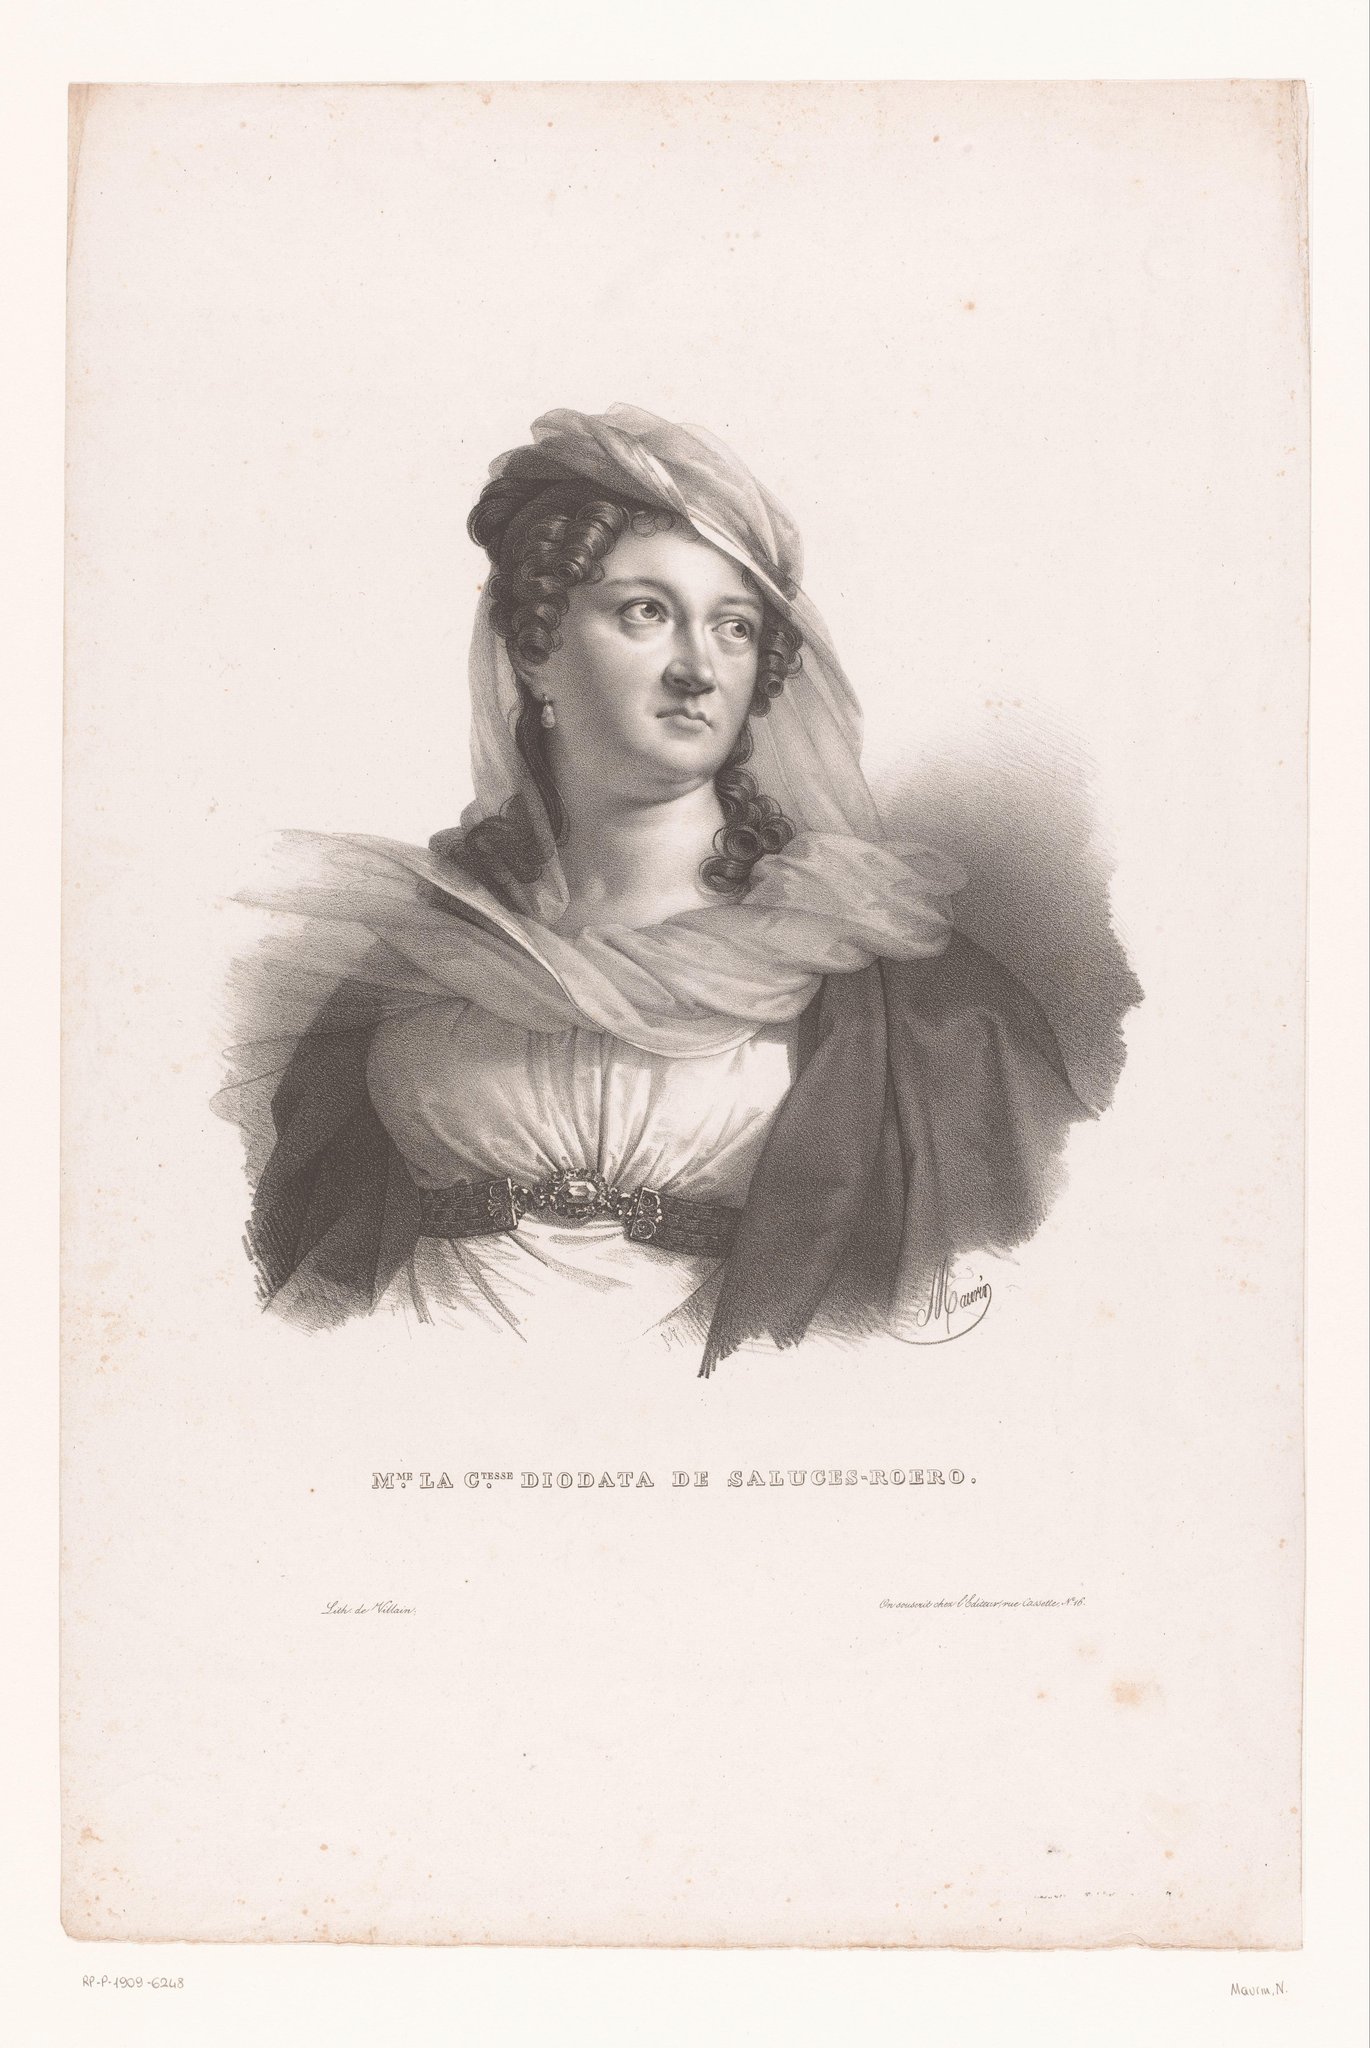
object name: print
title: Mme. la ctesse. Diodata de Saluces-Roero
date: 1827-1852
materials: paper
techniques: lithograph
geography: paris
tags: historical persons, writer, poet, author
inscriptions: check stamp: ‘JC’, collector's mark: Lugt 2228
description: Prent waarschijnlijk ook gebruikt in: Chabert, Jean Claude. Galerie des contemporaines, ou collection de portraits des femmes qui se sont rendues célèbres depuis la fin du dix-huitième siècle, en France et dans les pays étrangers. Avec des notices historiques / Galerie des contemporaines ou collection de portraits et biographies des femmes, qui se sont rendues célébres, depuis la fin du dix-huitième siècle, soit en France, soit dans les pays étrangers. Parijs: Jean Claude Chabert en Hennet fils, s.a. [1824-1827]. De samenstelling van tegenwoordig bekende en al dan niet gebonden exemplaren van deze uitgaven verschillen. Dit omdat de prenten en bijhorende stukken tekst op inschrijving en waarschijnlijk ook los verkrijgbaar waren.